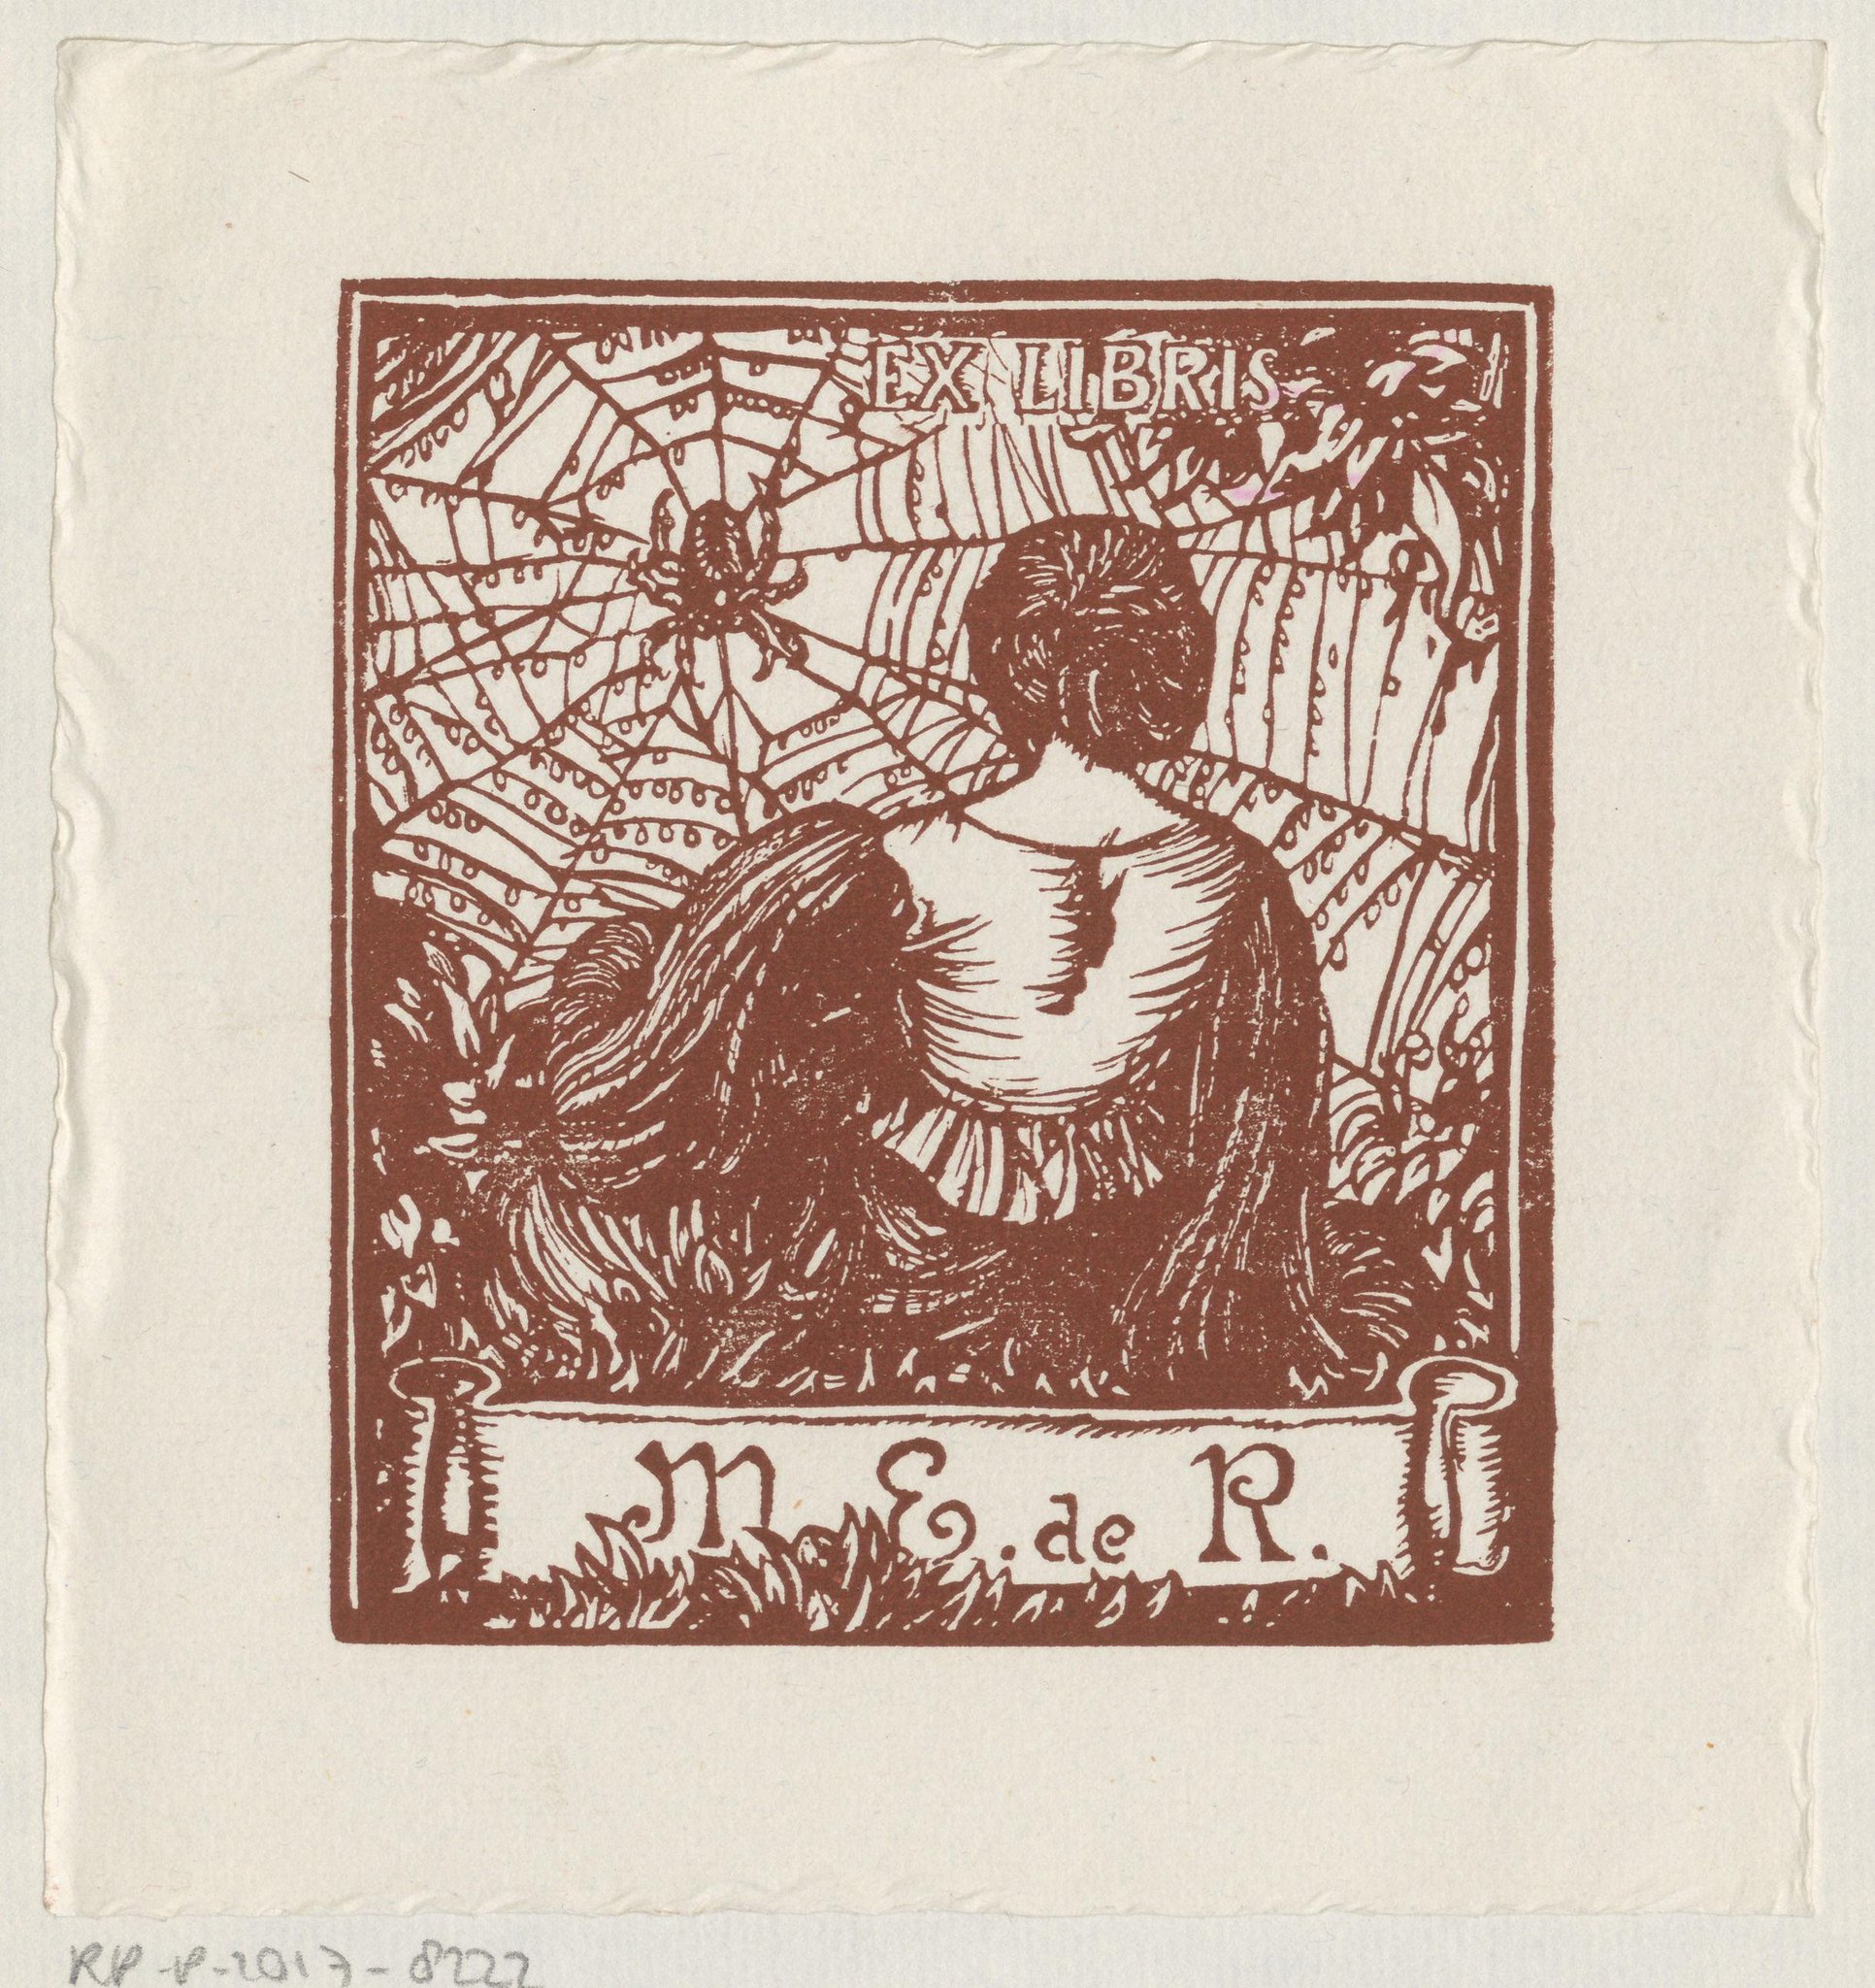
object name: bookplate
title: Ex libris van M.E. de R.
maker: Anonymous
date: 1936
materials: paper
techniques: printing block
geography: london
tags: sitting figure - aa - female human figure, spiders